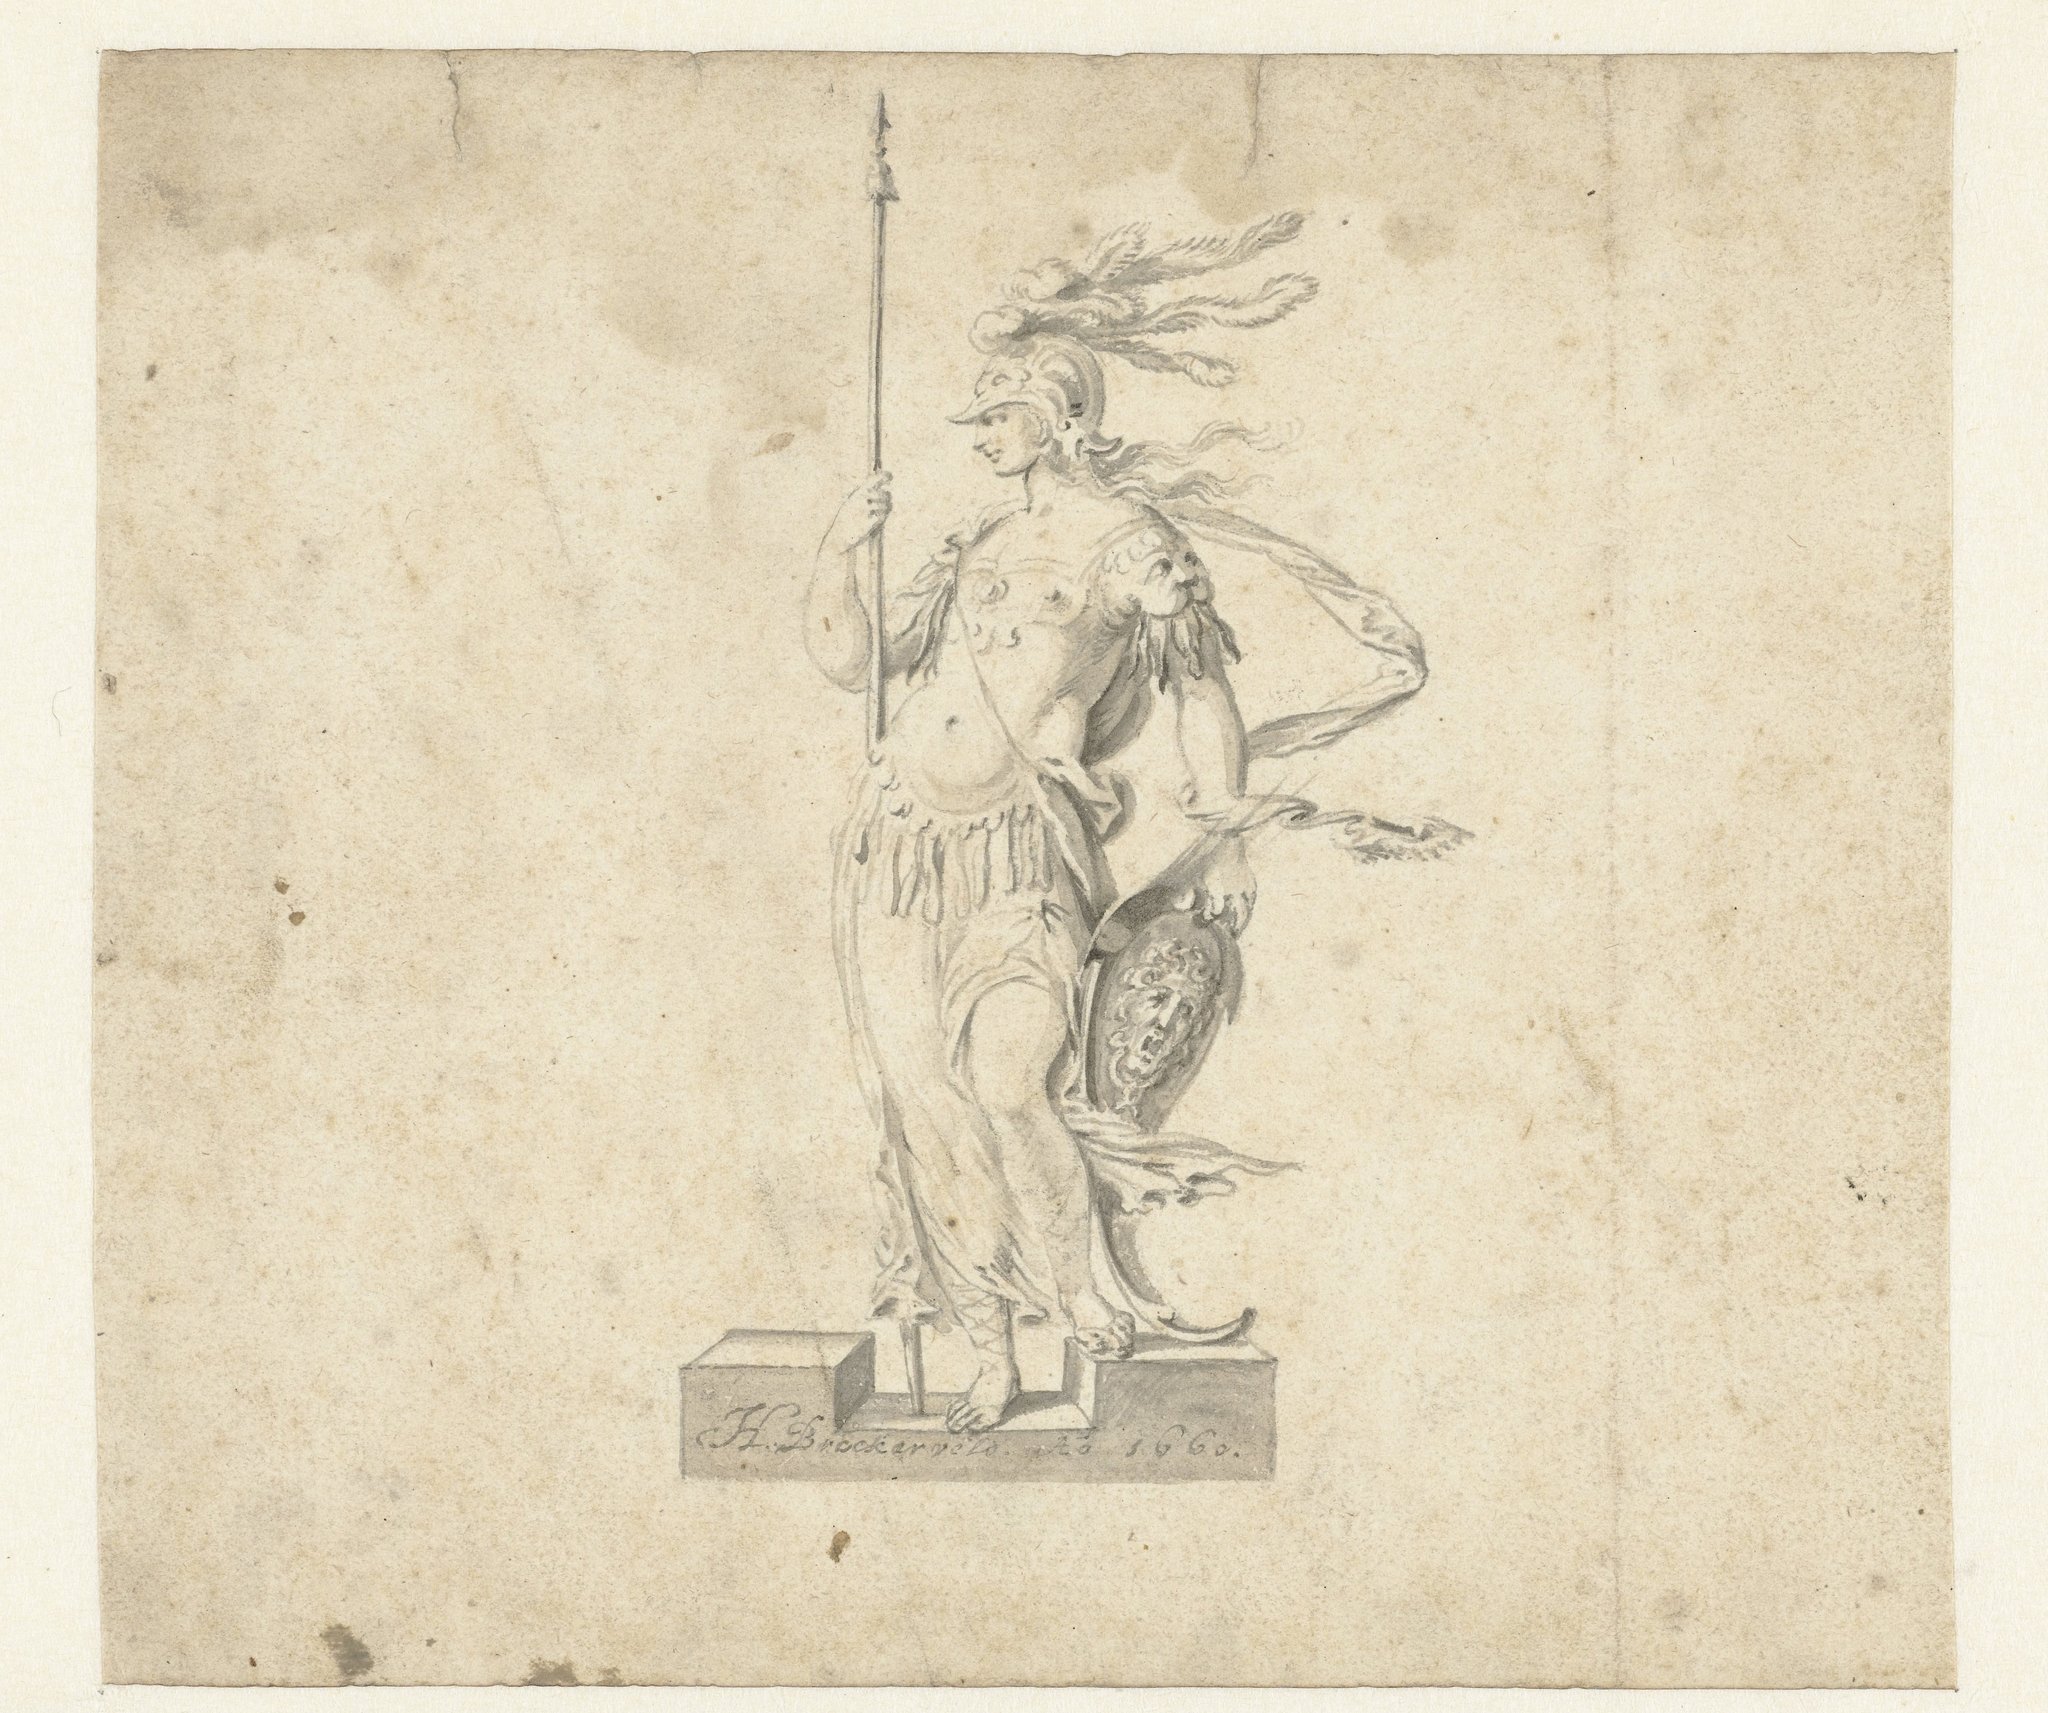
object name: drawing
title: Staande Minerva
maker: herman breckerveld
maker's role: draughtsman, print maker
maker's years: 1595-1673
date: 1660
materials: ink, paper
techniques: brush, pen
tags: (story of) minerva (pallas, athena)